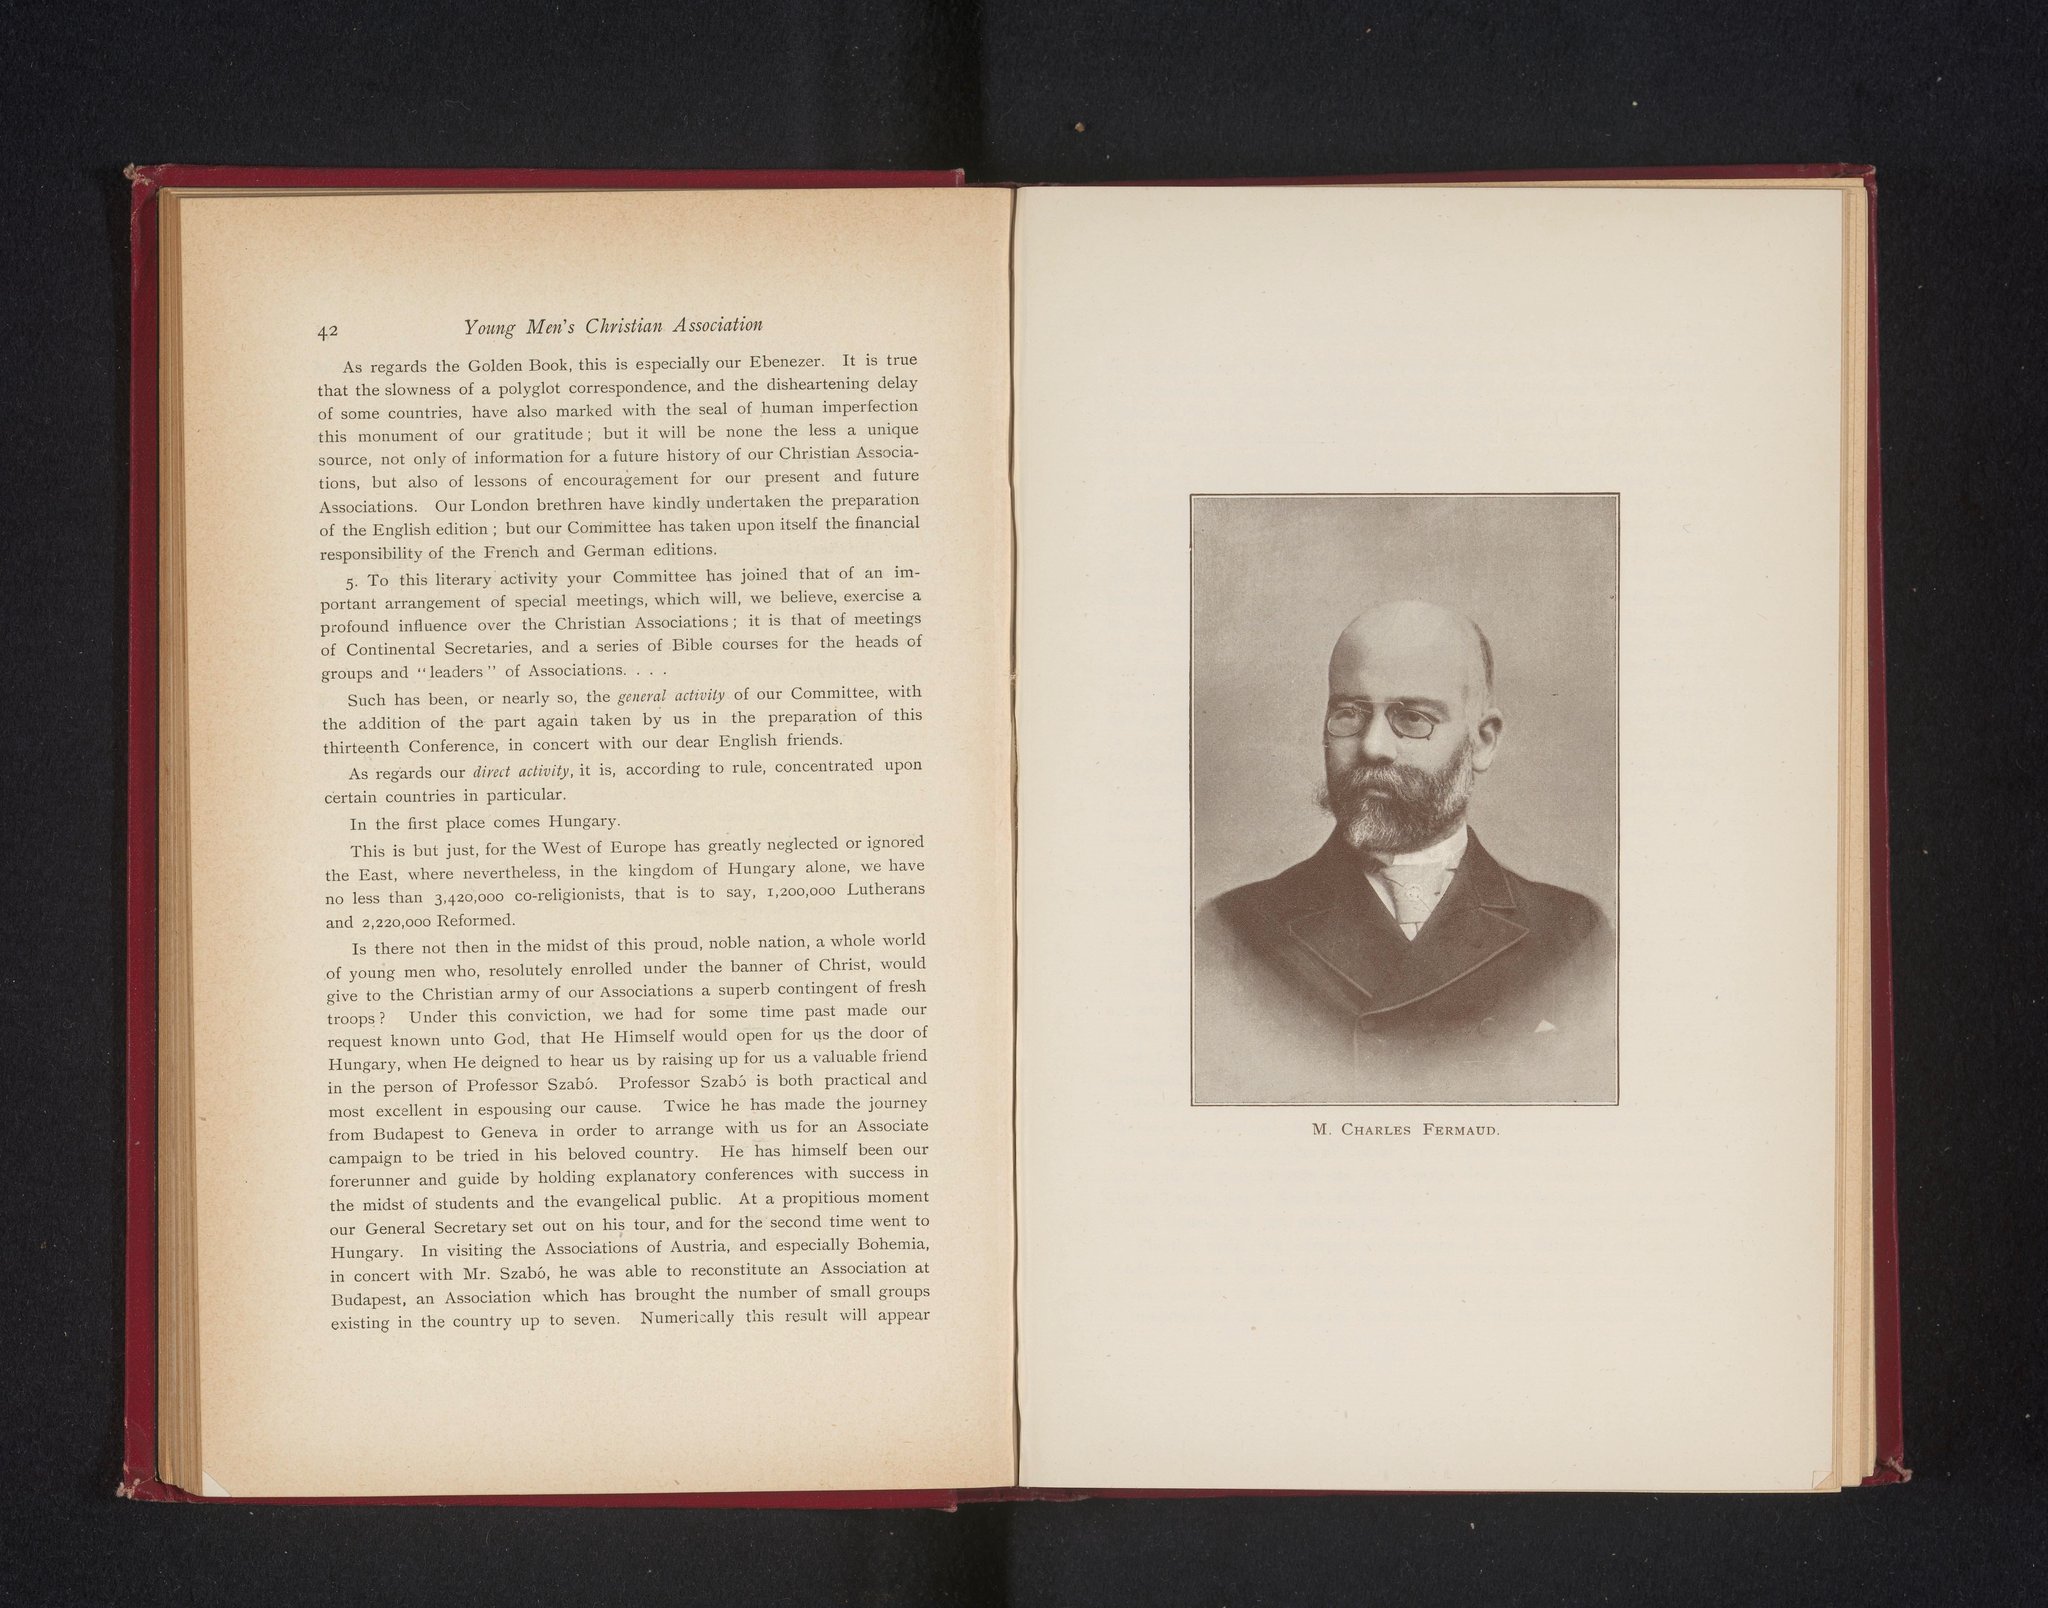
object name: photomechanical print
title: Portret van Charles Fermaud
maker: Anonymous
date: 1890-1895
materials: paper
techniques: autotype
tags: historical persons